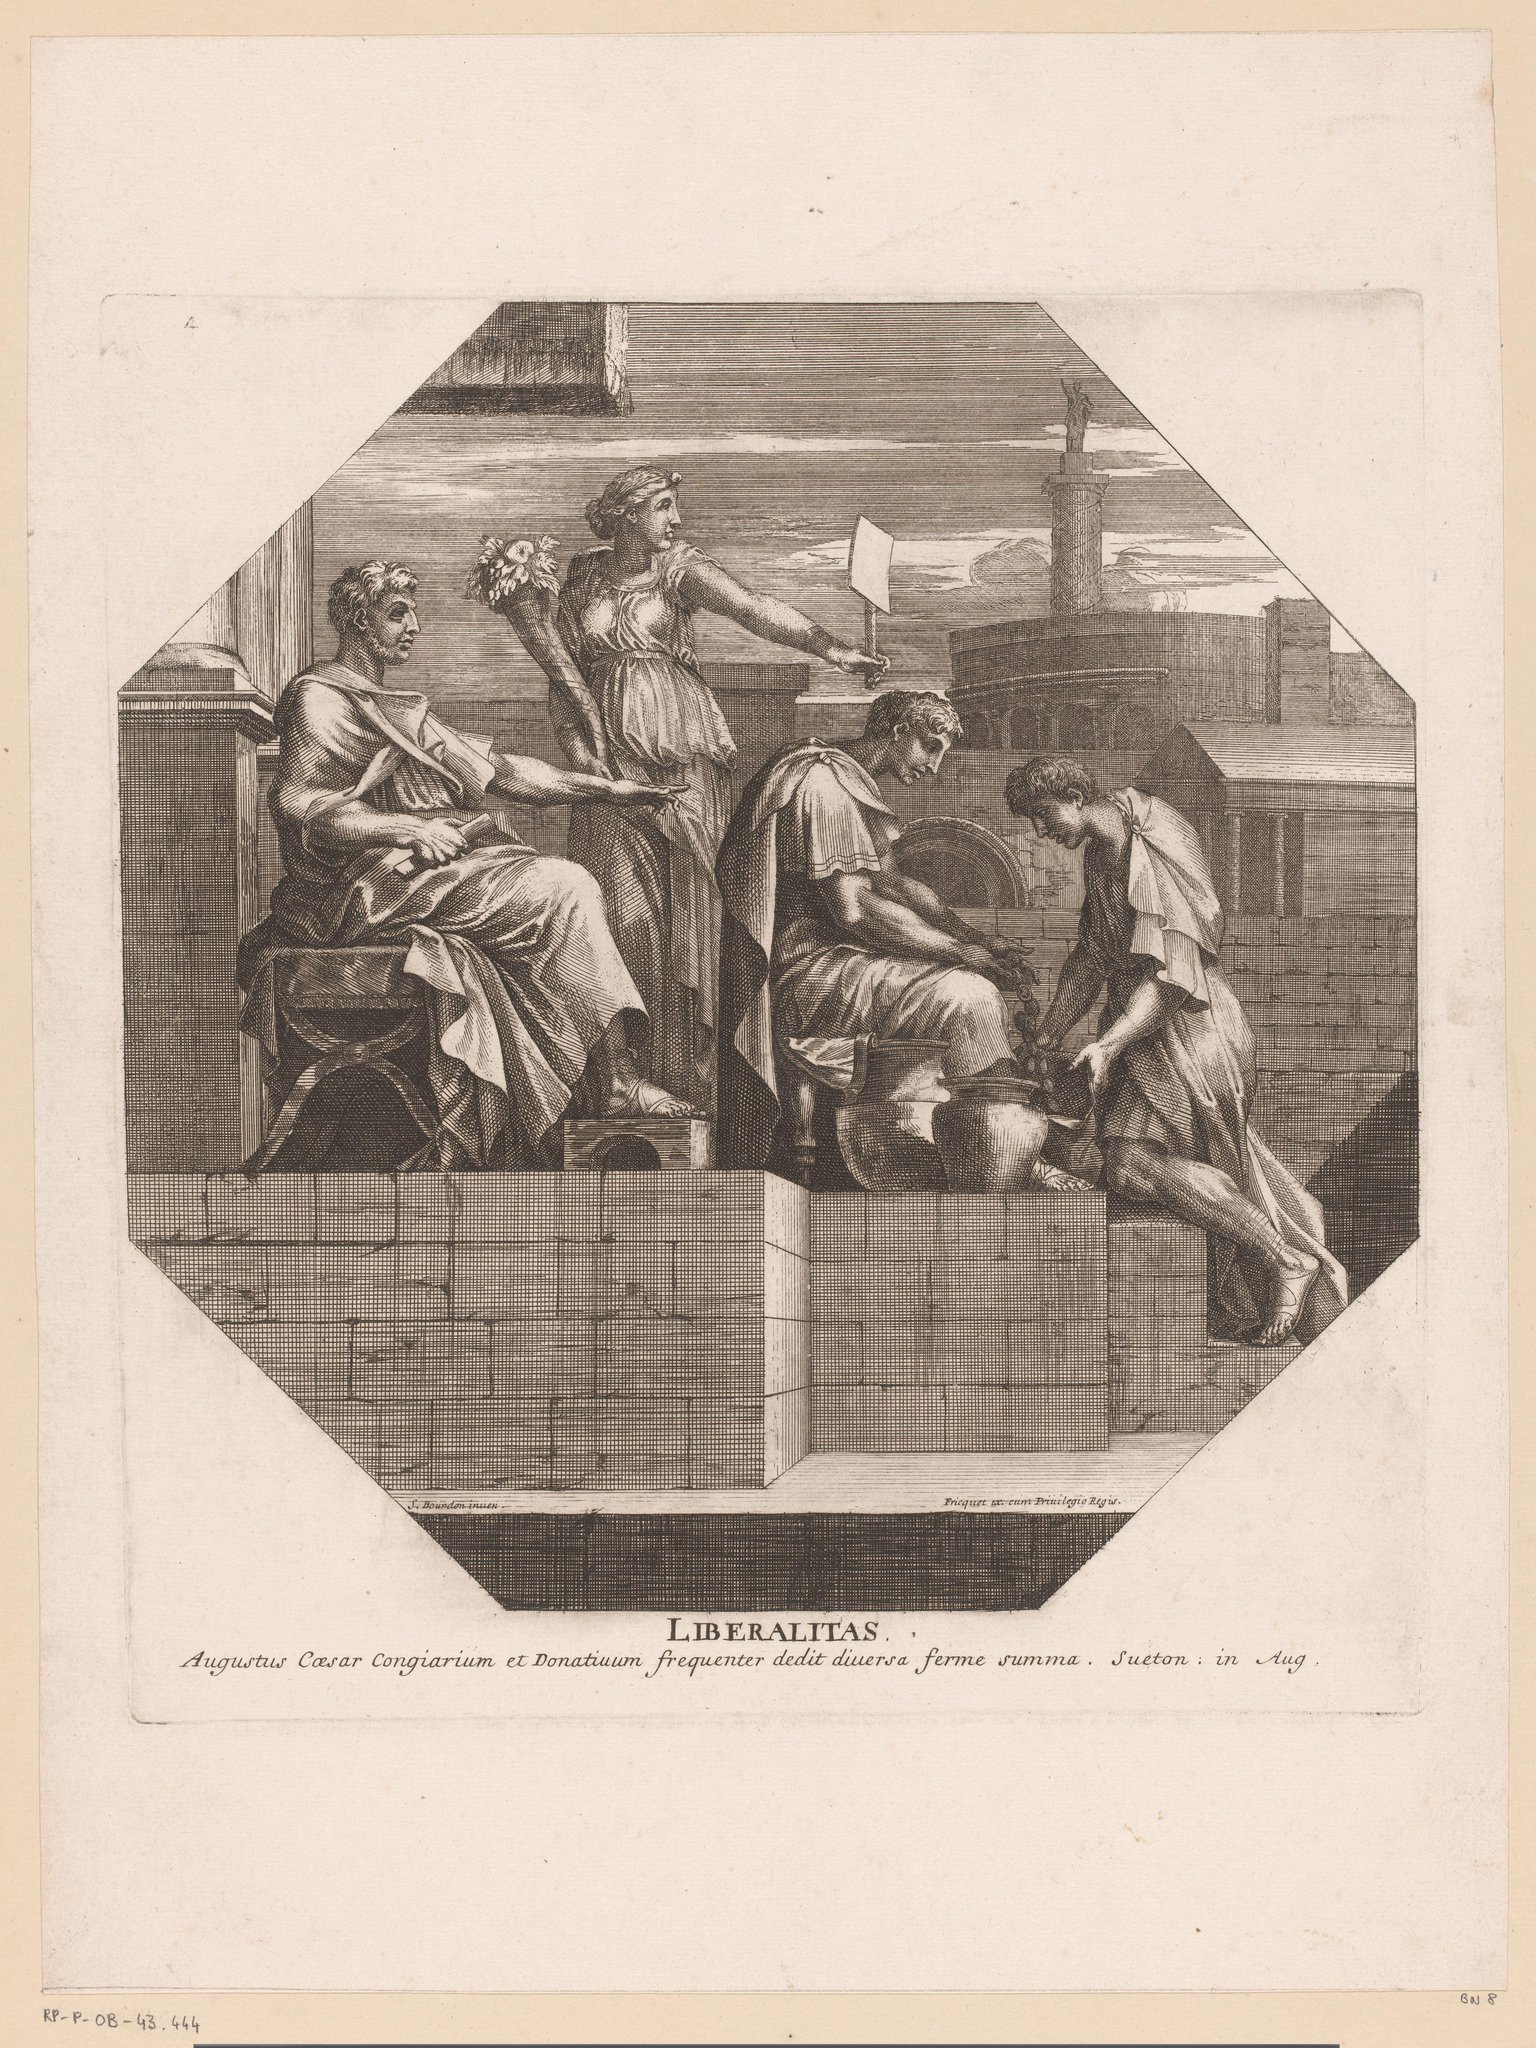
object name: print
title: Liberalitas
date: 1663-1716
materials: paper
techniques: engraving, etching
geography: france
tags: historical persons, generosity, liberality; 'generosità', 'liberalità' (ripa)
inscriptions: collector's mark: Lugt 240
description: Maakt deel uit van een veertiendelige serie opgedeeld in twee reeksen, met als onderwerp de zeven vrije kunsten en deugden naar schilderijen door Sébastien Bourdon. De schilderijen werden in 1663 vervaardigd voor de Grande Galerie van het Hôtel de Bretonvilliers te Parijs.